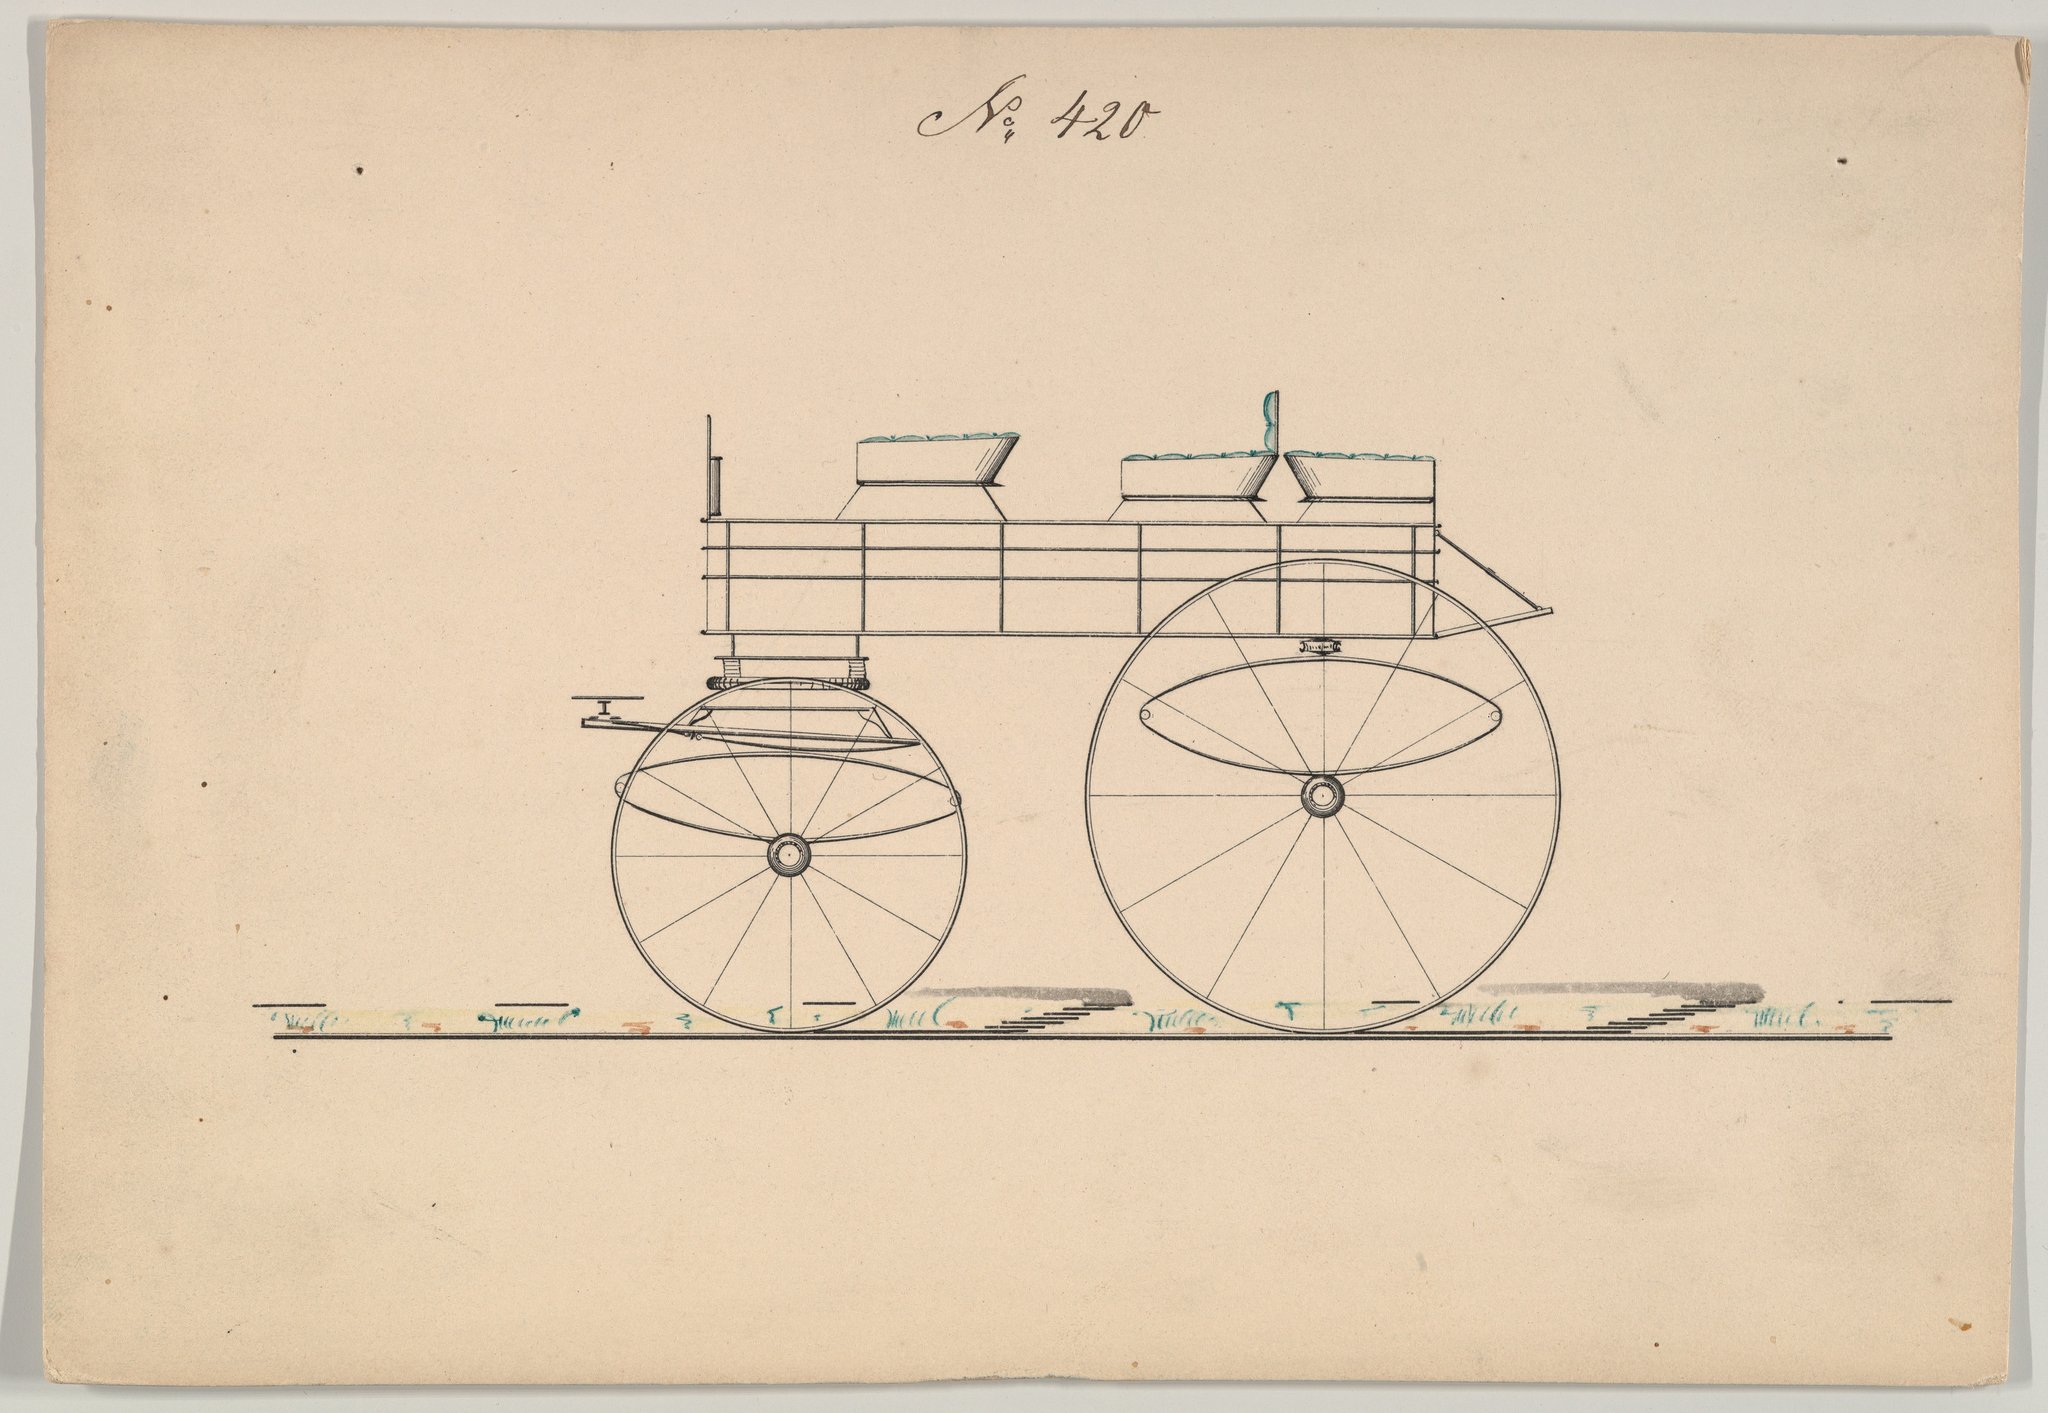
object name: drawing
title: Carriage Design Drawing for Express Wagon No. 420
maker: brewster & co.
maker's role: manufacturer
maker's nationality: american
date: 1850-1870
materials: ink, watercolor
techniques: pen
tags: carriages